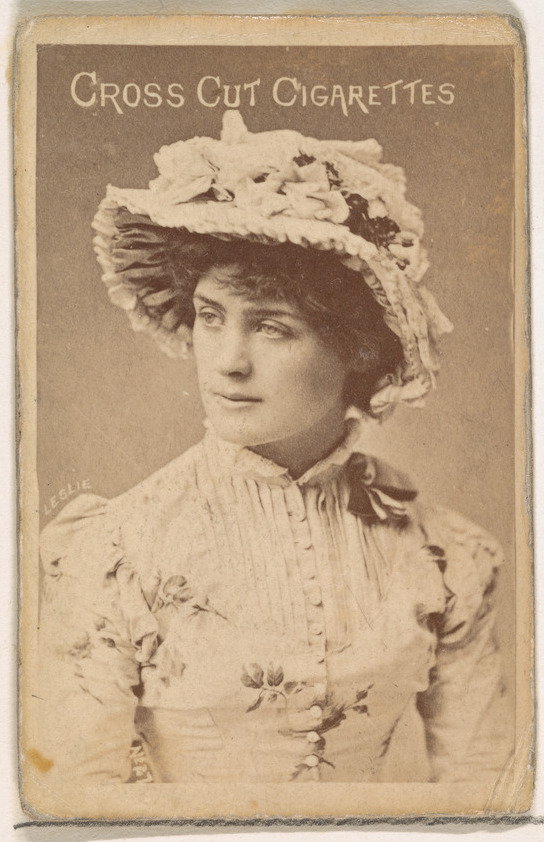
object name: print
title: Leslie, from the Actors and Actresses series (N145-1) issued by Duke Sons & Co. to promote Cross Cut Cigarettes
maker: w. duke, sons & co.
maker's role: publisher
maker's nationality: american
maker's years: 1870-1920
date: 1880-1889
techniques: albumen silver print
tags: portraits,women,actresses